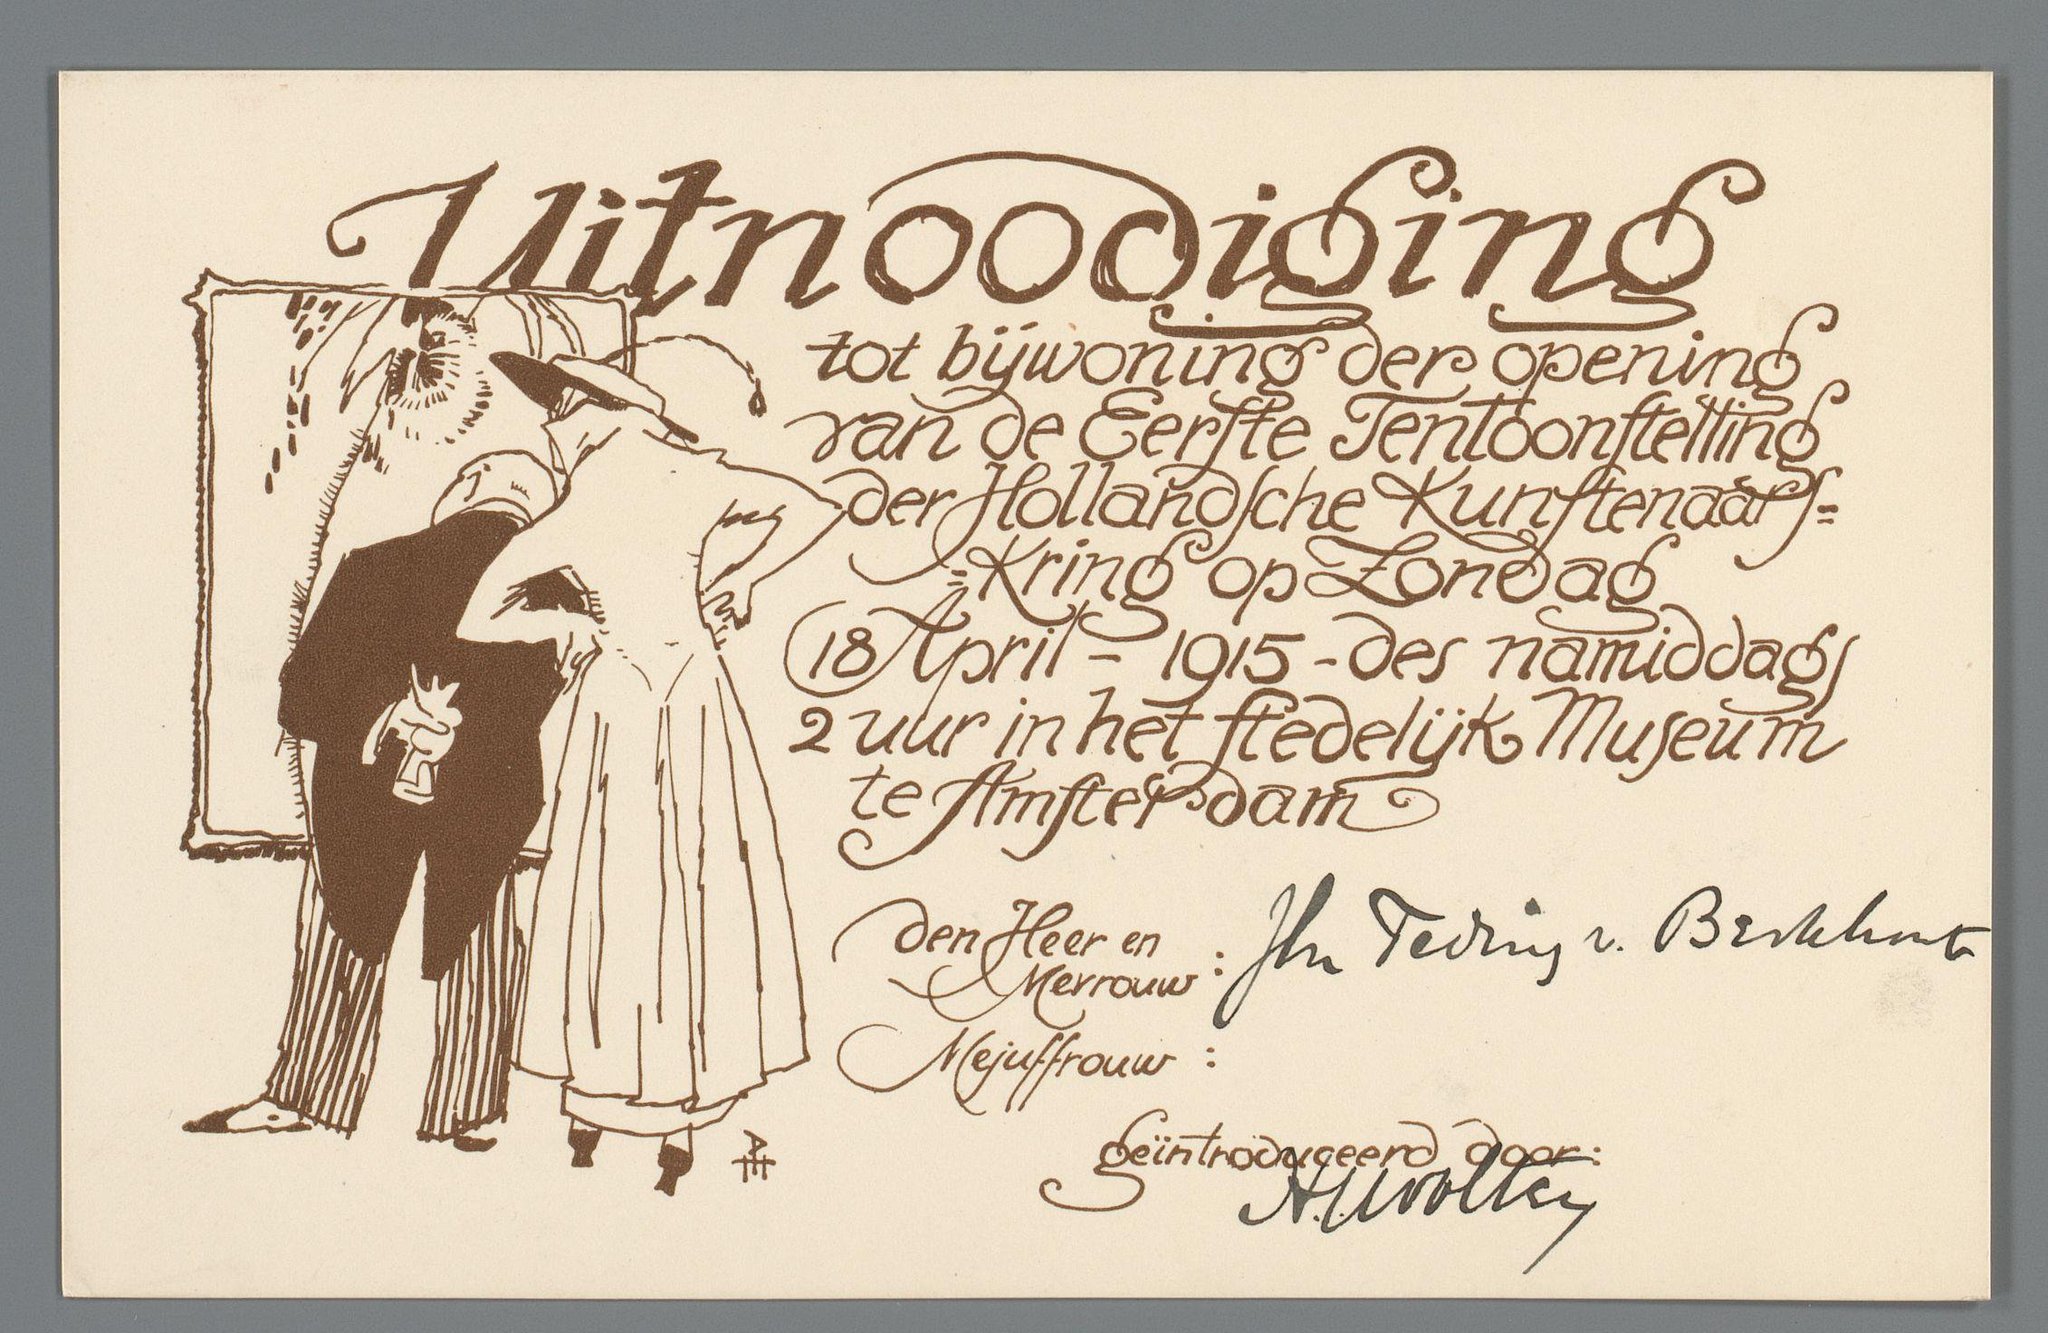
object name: photomechanical print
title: Uitnodiging voor de opening van de Eerste Tentoonstelling der Hollandsche Kunstenaarskring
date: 1915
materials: paper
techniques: printing block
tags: picture, painting, collection, exhibition, show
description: Een man en vrouw staan een schilderij te bestuderen. Daarnaast de tekst: 'Uitnoodiging tot bijwoning der opening van de Eerste Tentoonstelling der Hollandsche Kunstenaarskring op Zondag 18 april 1915 des namiddags 2 uur in het Stedelijk Museum te Amsterdam. Daaronder is in handschrift de geadresseerde van deze uitnodiging ingevuld (Jhr. Teding van Berkhout), en daaronder de afzender (onleesbaar).